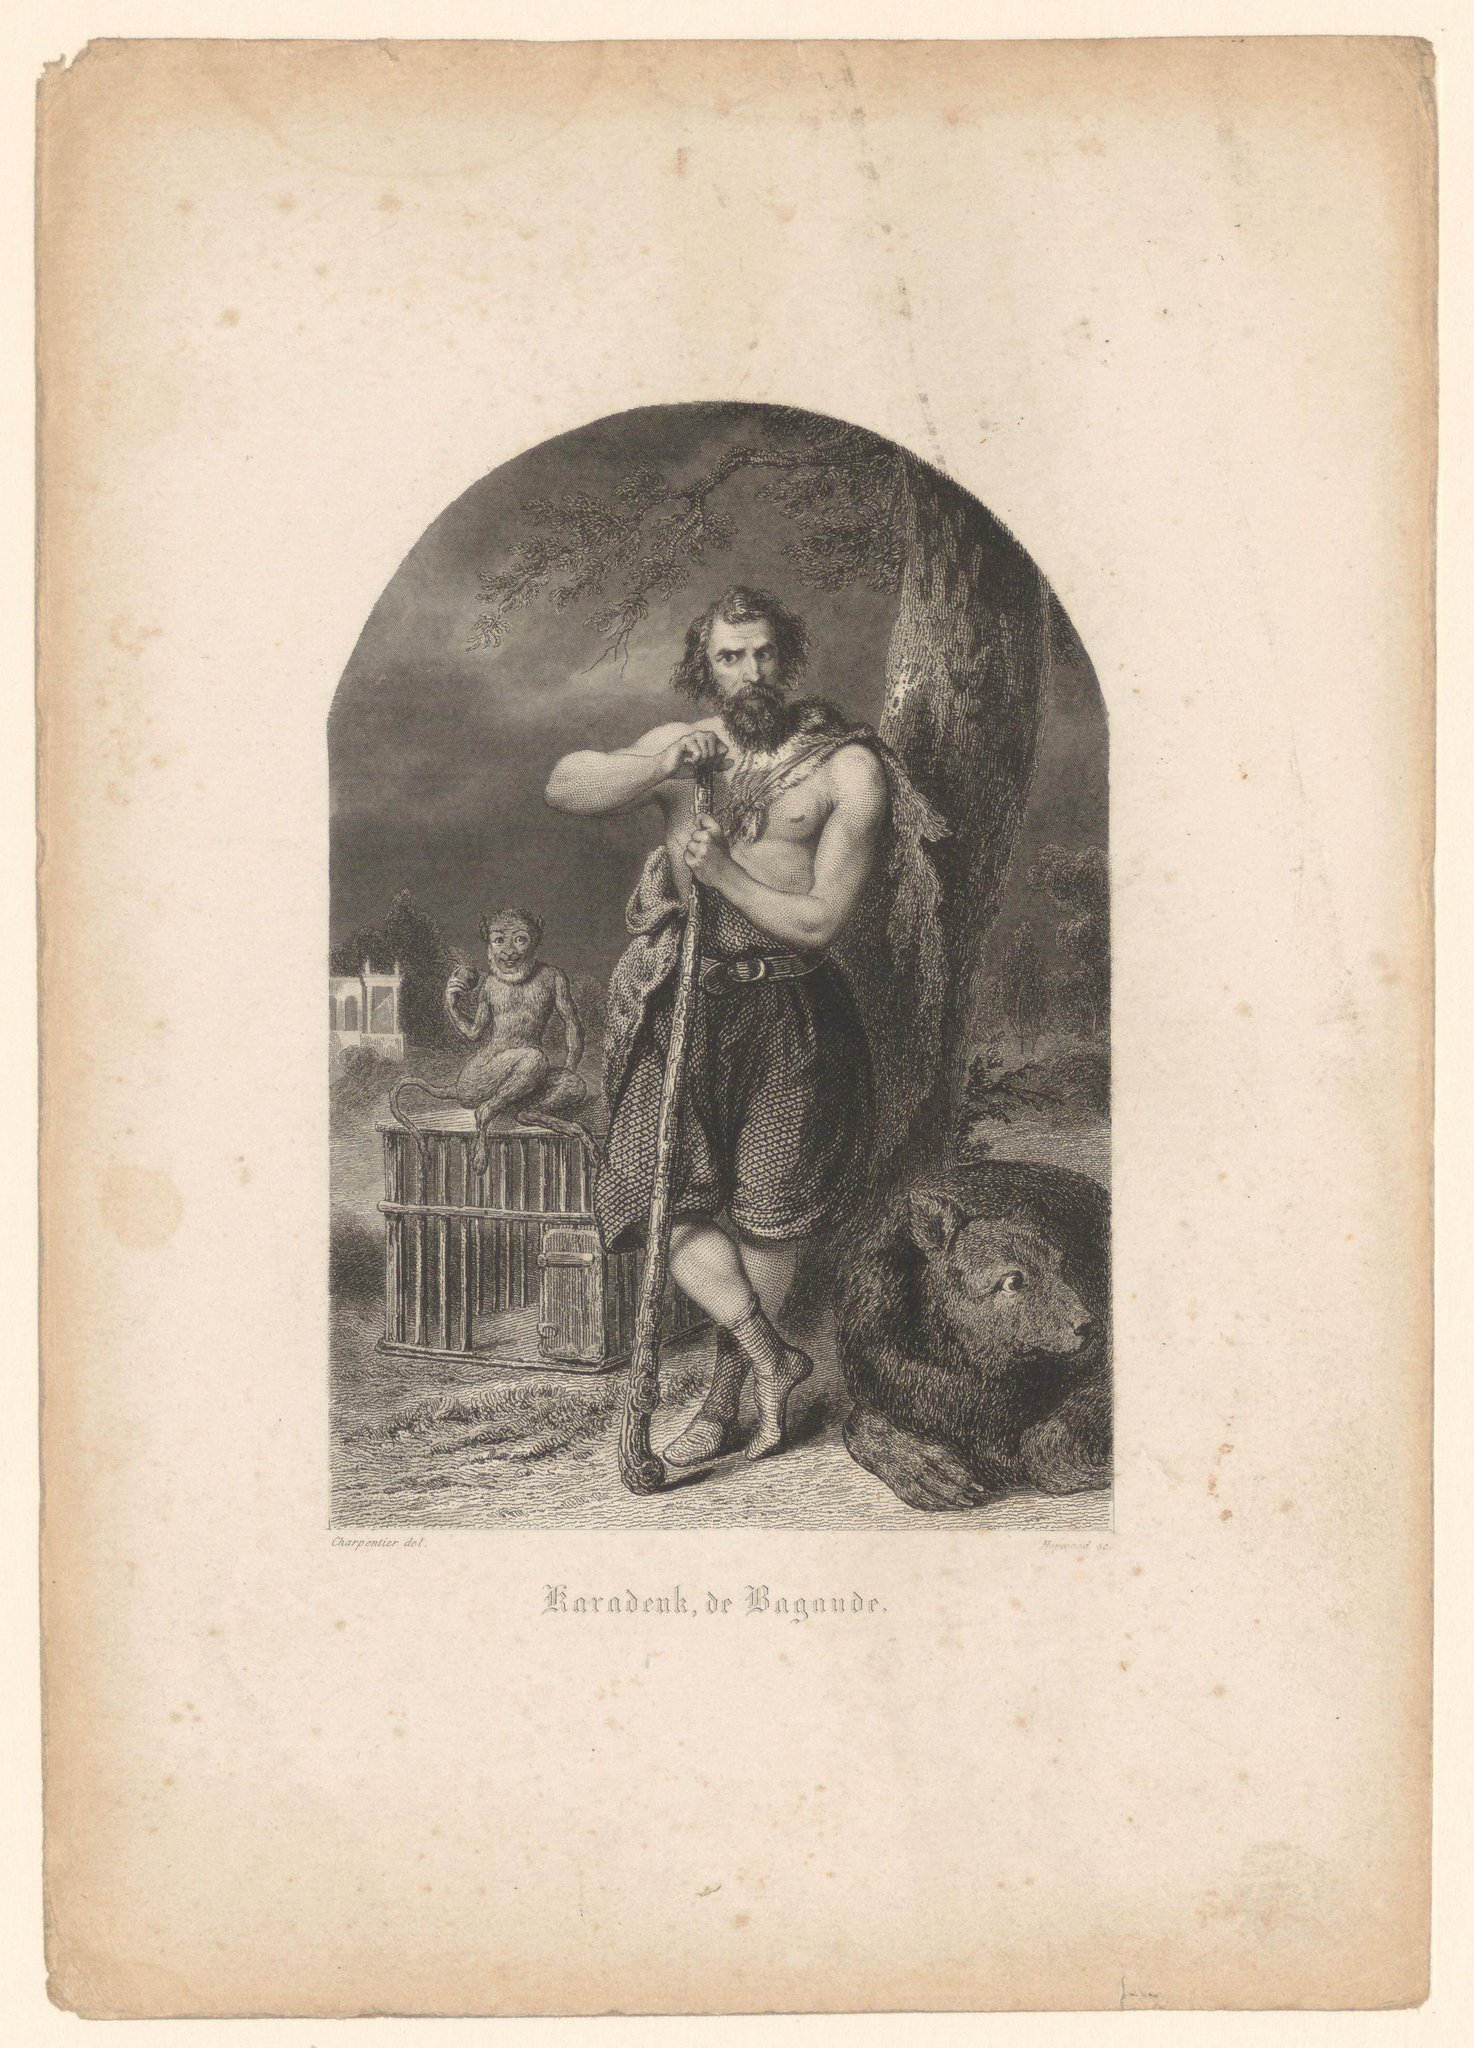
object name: print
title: Karadeuk, de Bagaude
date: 1851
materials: paper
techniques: etching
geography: amsterdam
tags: standing figure, monkeys, apes, beasts of prey, predatory animals: bear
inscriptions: collector's mark: Lugt 2228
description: Prent uit: Sue, Eugène. De Verborgenheden des Volks, of geschiedenis van een Arbeiders-geslacht, door de eeuwen heen. Amsterdam: M.H. Binger en Zonen, 1851, dl. 4, tussen p. 126 en 127.